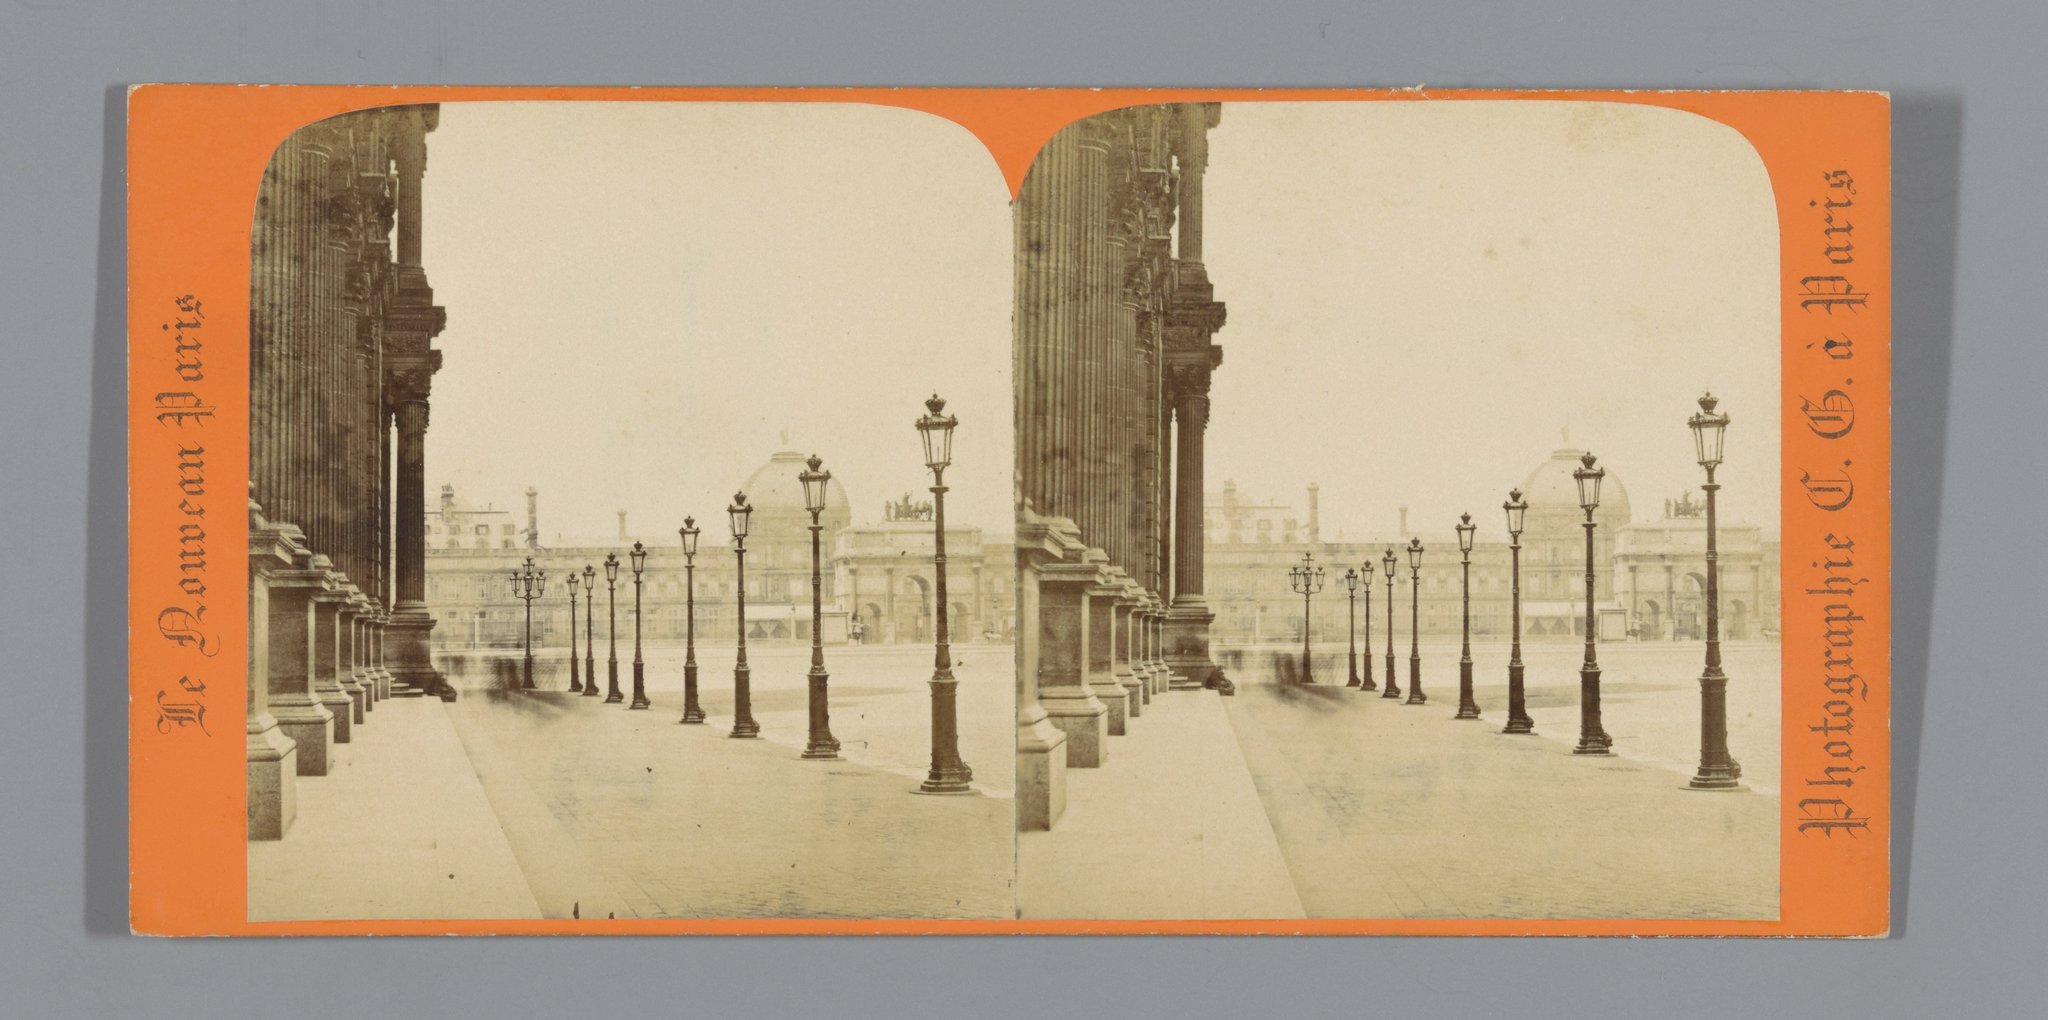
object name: stereograph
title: Gezicht op de Place du Carrousel te Parijs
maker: charles gérard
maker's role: fotograaf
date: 1860-1870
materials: cardboard, photographic support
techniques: albumen print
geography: place du carrousel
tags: square, place, circus, etc.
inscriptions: inscription: ‘Photographie C. G. à Paris.’, inscription: ‘Place du Carrousel’